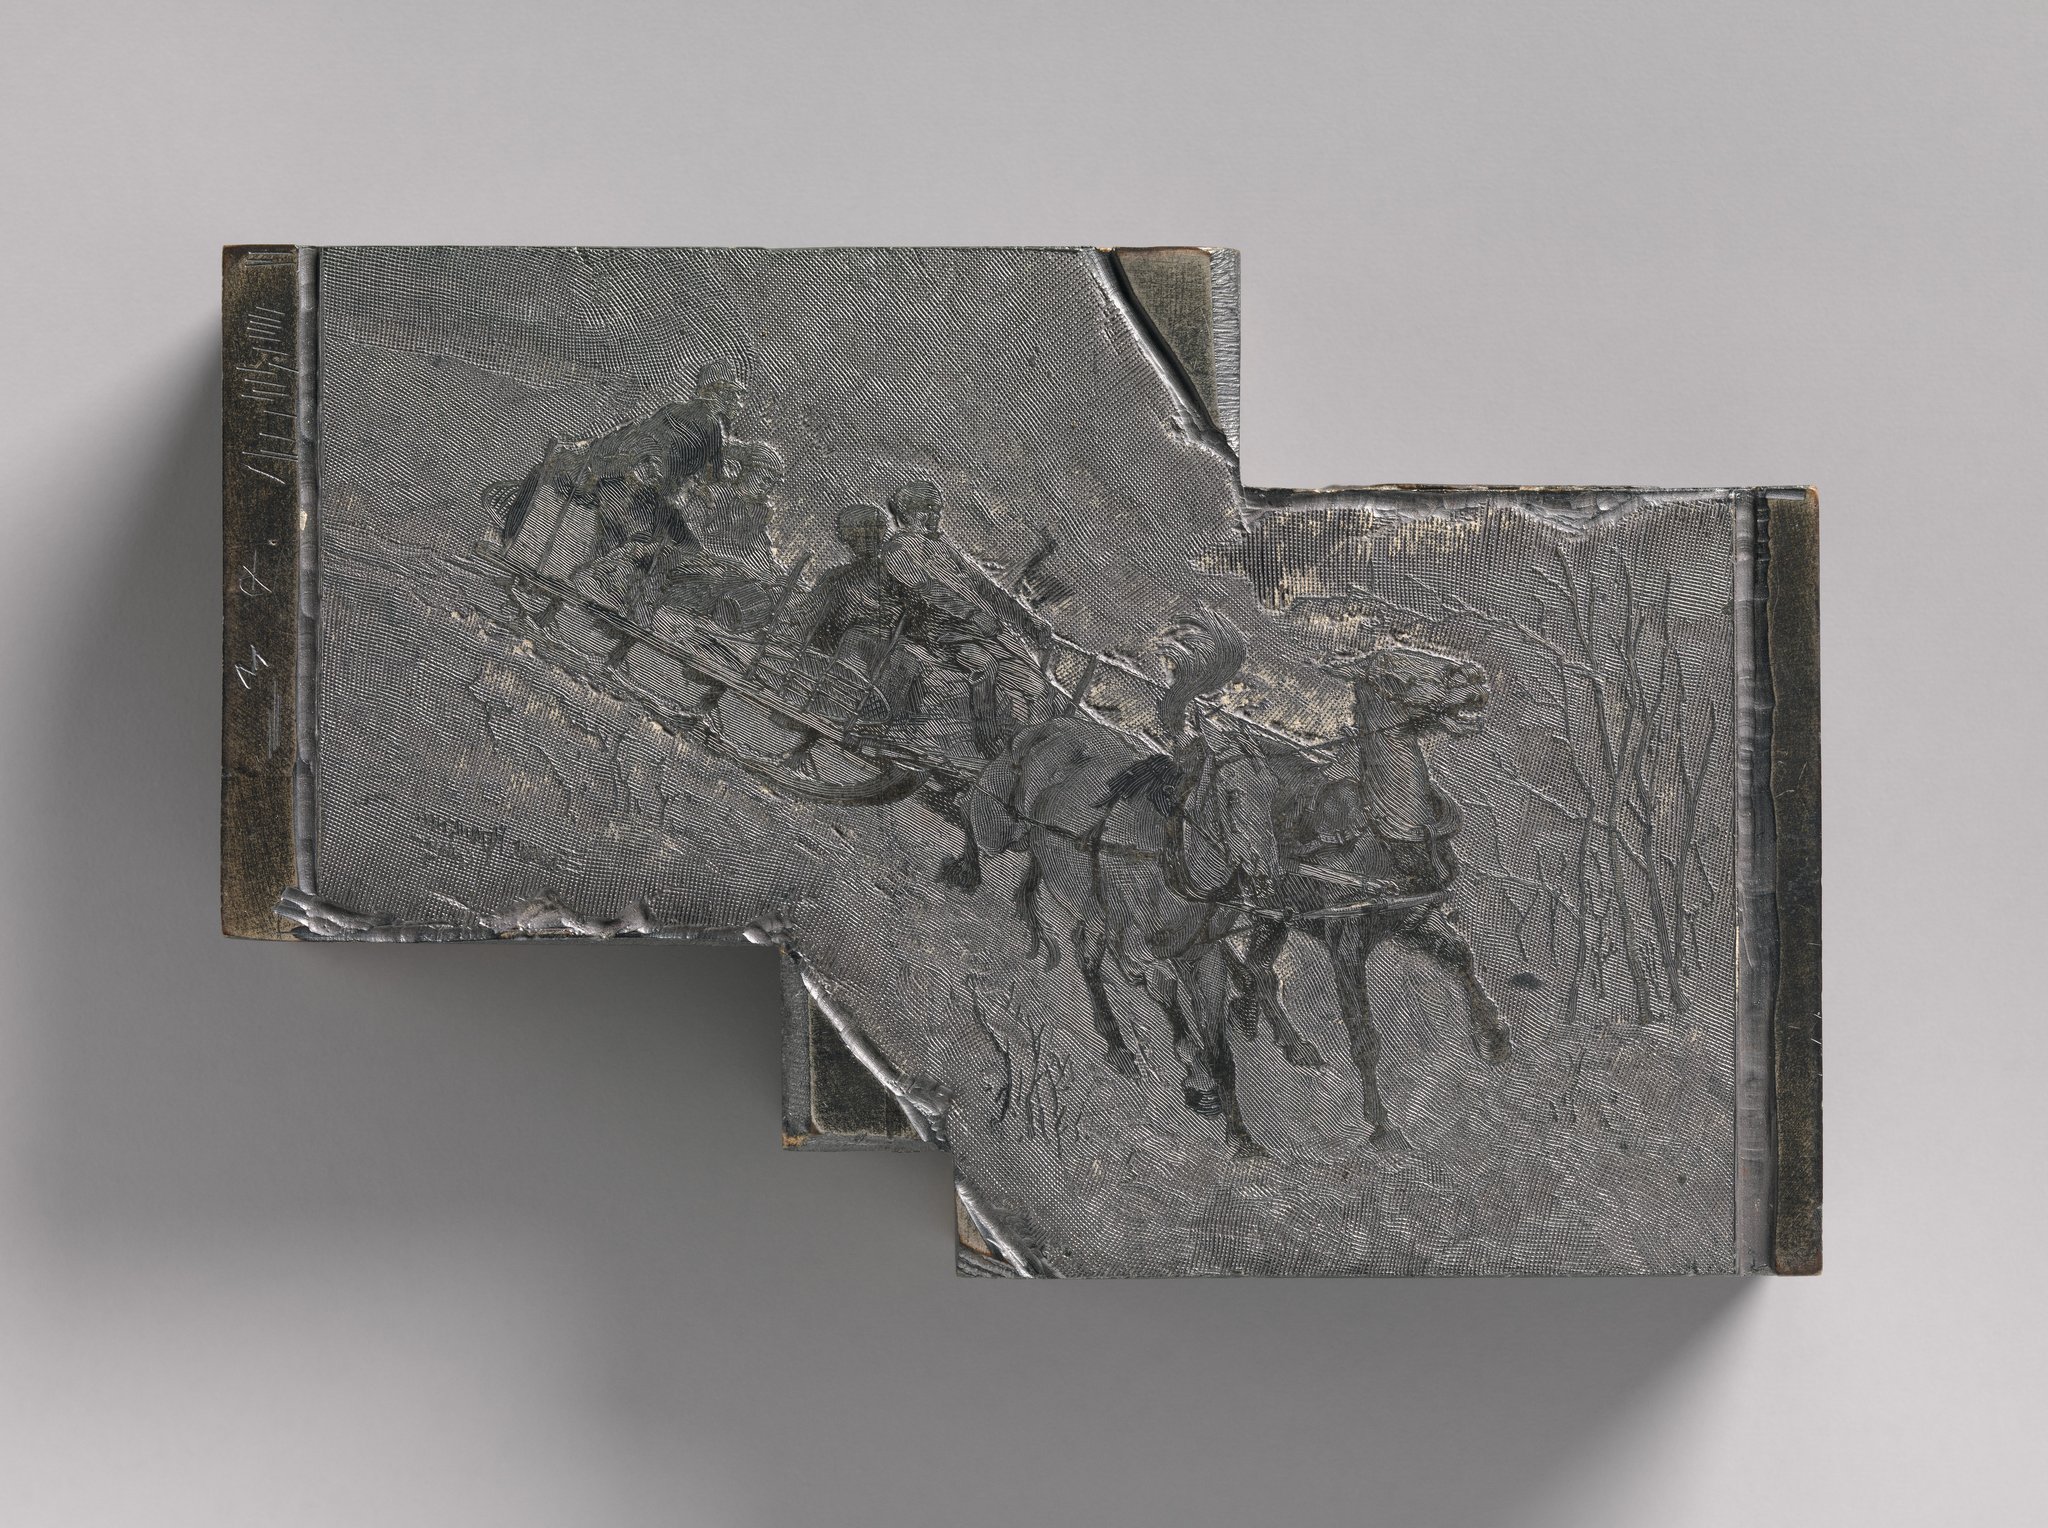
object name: block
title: The Portage Sleigh on a Lumber Road, for "Antoine's Moose-Yard," for "Harper's New Monthly Magazine," October 1890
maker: frederic remington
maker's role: artist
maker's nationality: american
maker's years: 1861-1909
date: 1890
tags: human figures,horses